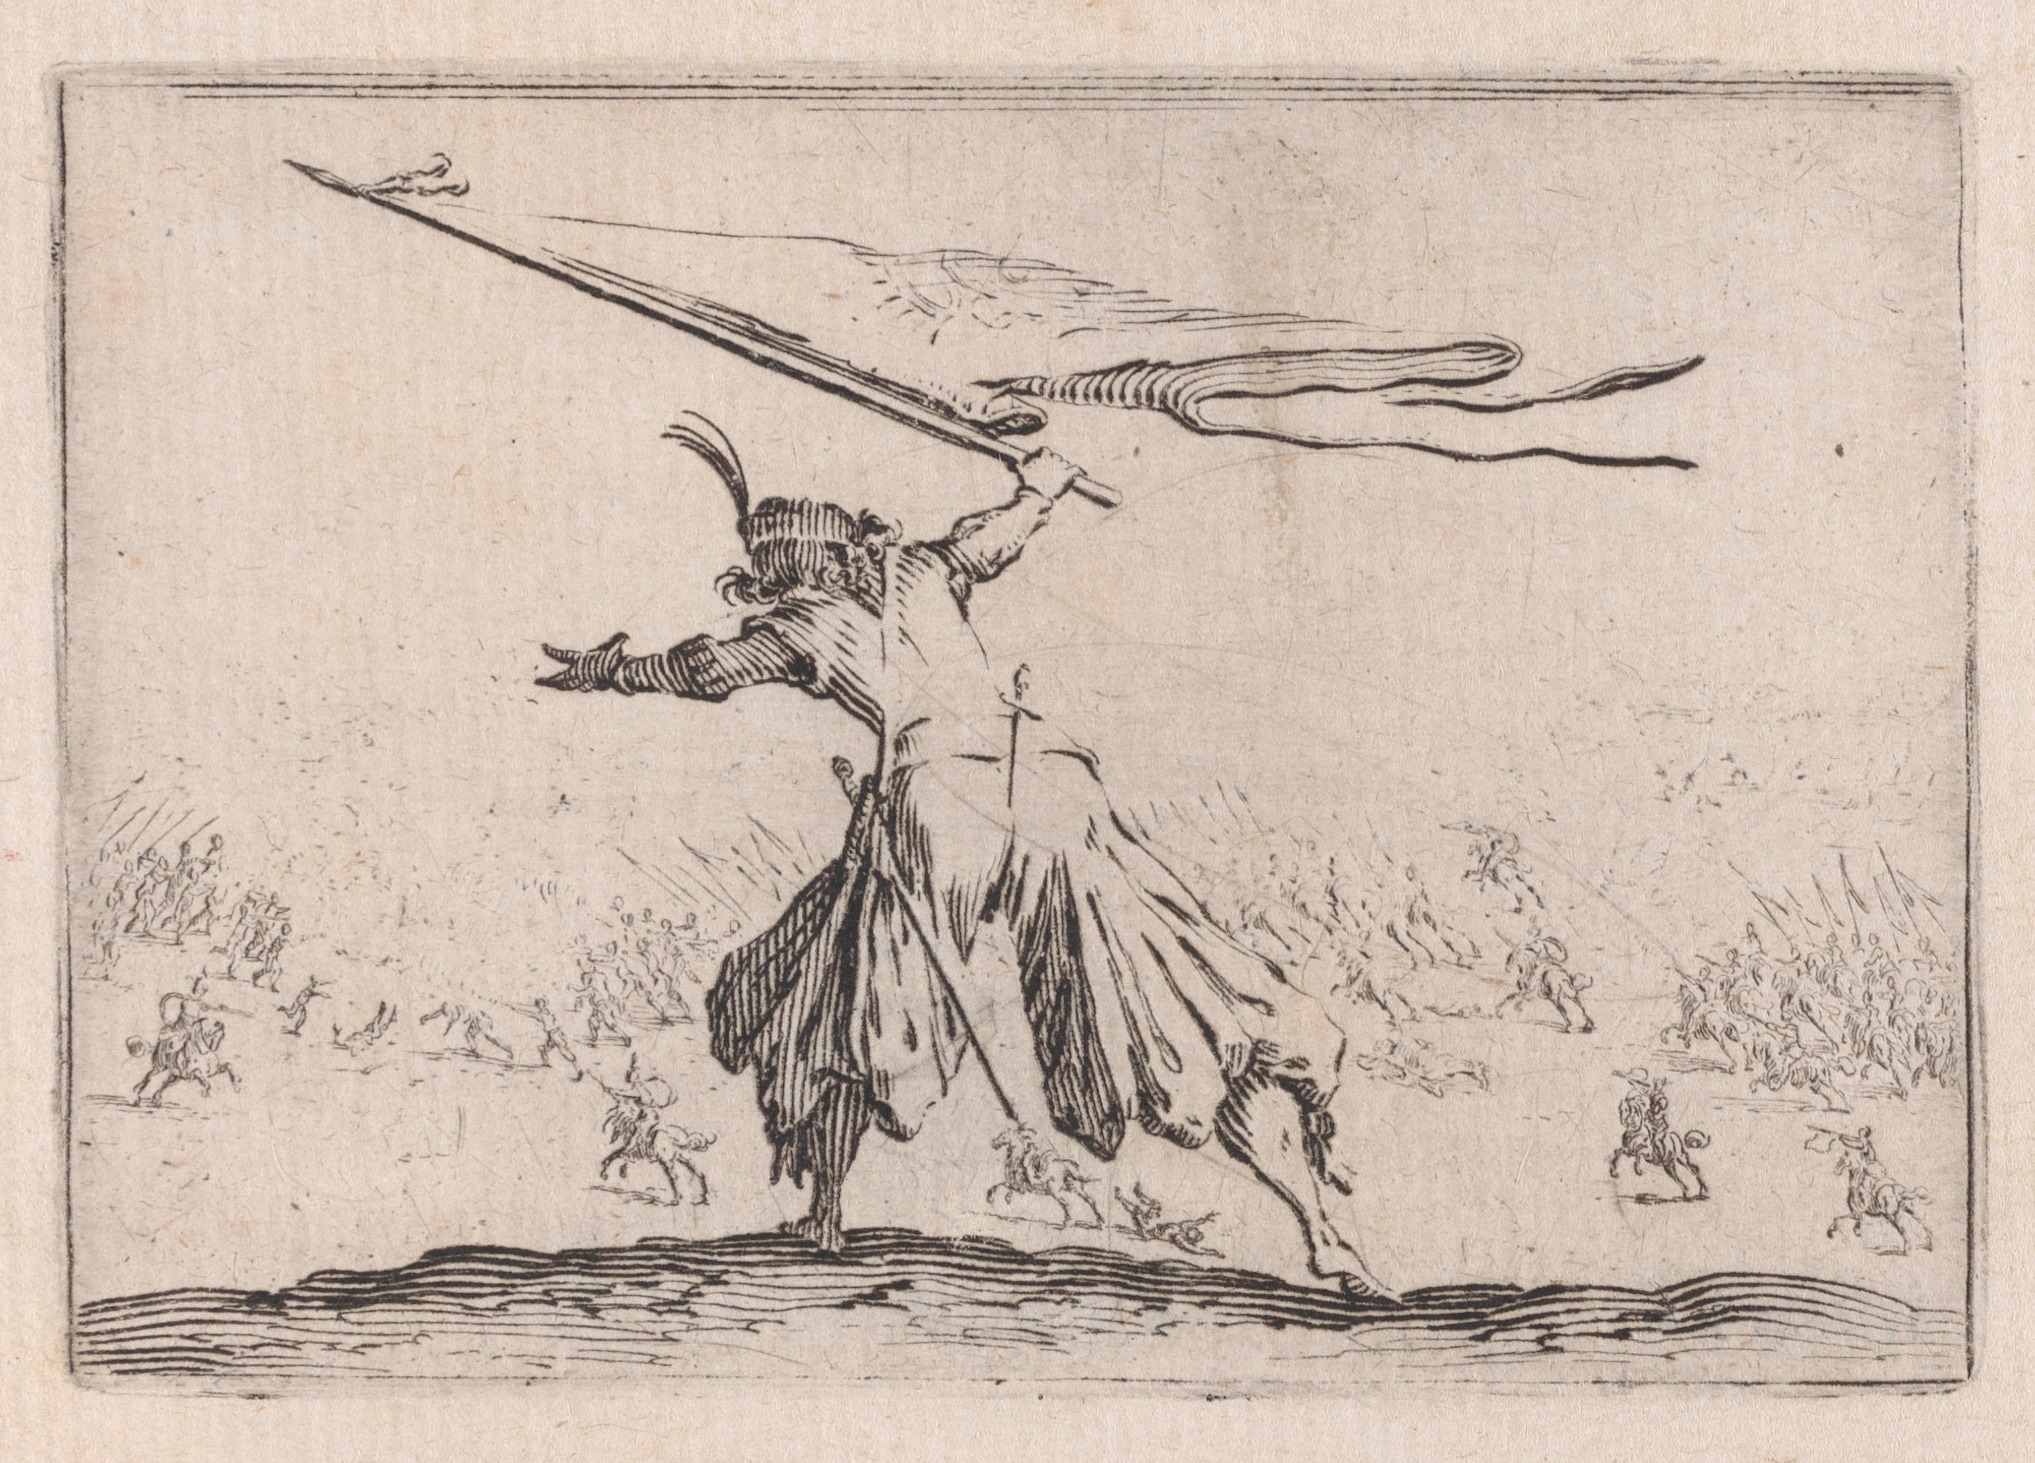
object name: print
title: Le Porte-Étendard (The Standard Bearer), from "Les Caprices" Series B, The Nancy Set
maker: jacques callot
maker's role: artist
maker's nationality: french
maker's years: 1592-1635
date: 1617-1620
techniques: etching